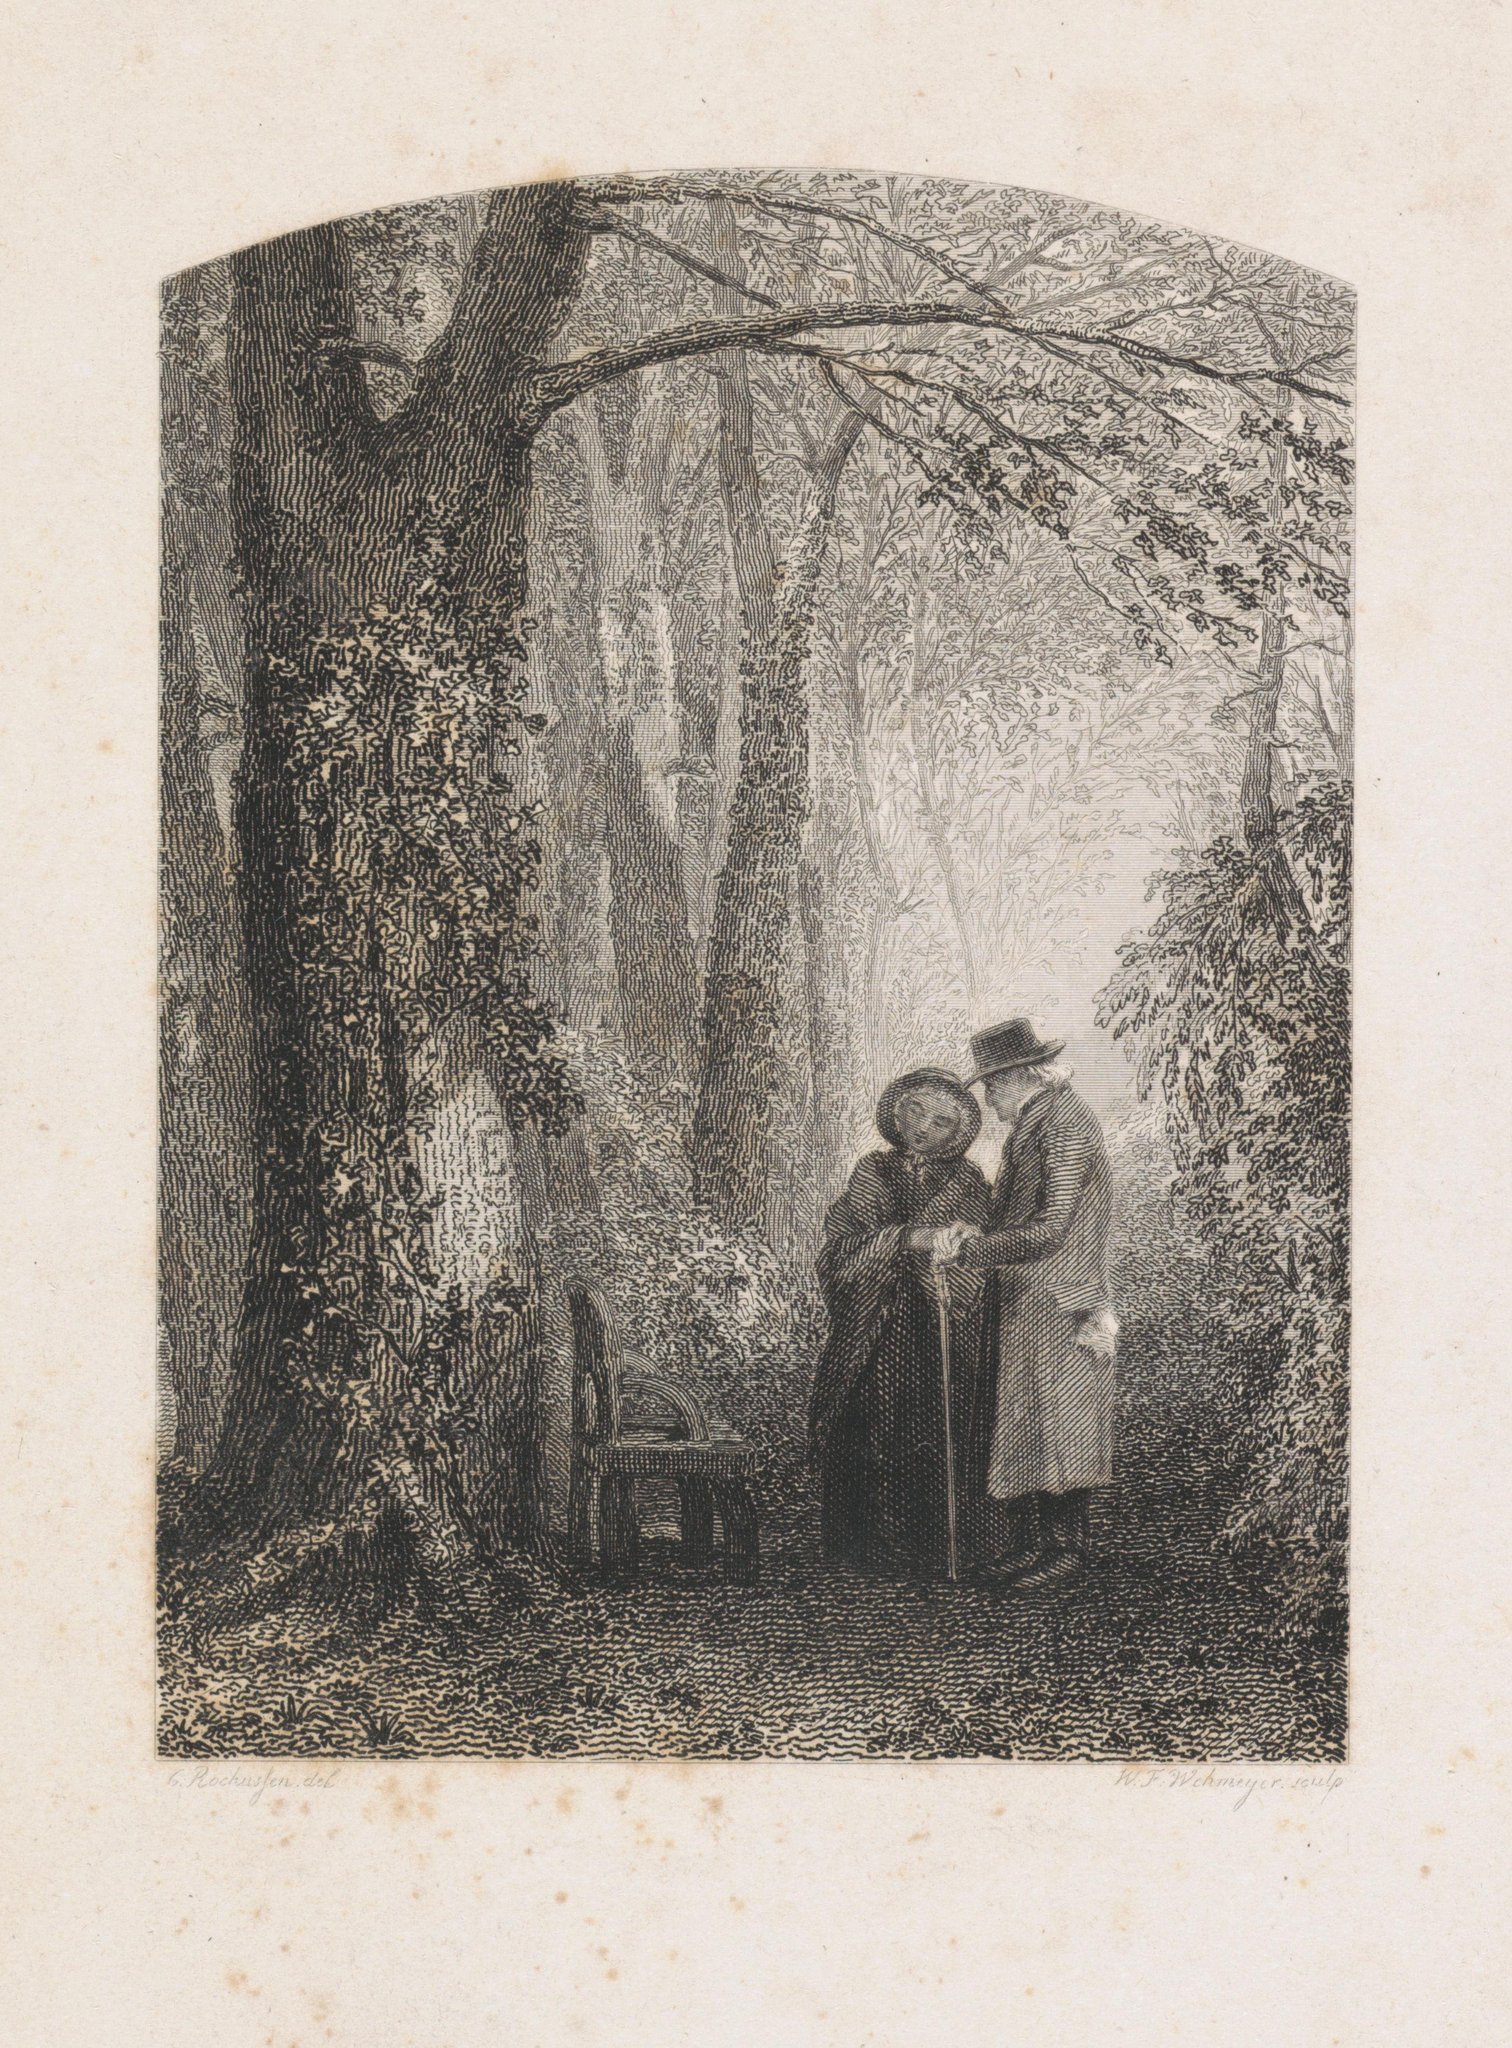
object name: print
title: Ouder echtpaar in een bos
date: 1834-1854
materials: paper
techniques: engraving, etching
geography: amsterdam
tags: old man, old woman, forest, wood (+ landscape with figures, staffage), chair, couple of lovers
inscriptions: collector's mark: Lugt 2228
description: In een bos staat een ouder echtpaar met een stok. In de schors van de linkerboom is de hoofdletter 'E' met een cirkel gekrast. Voor de boom staat een stoel.